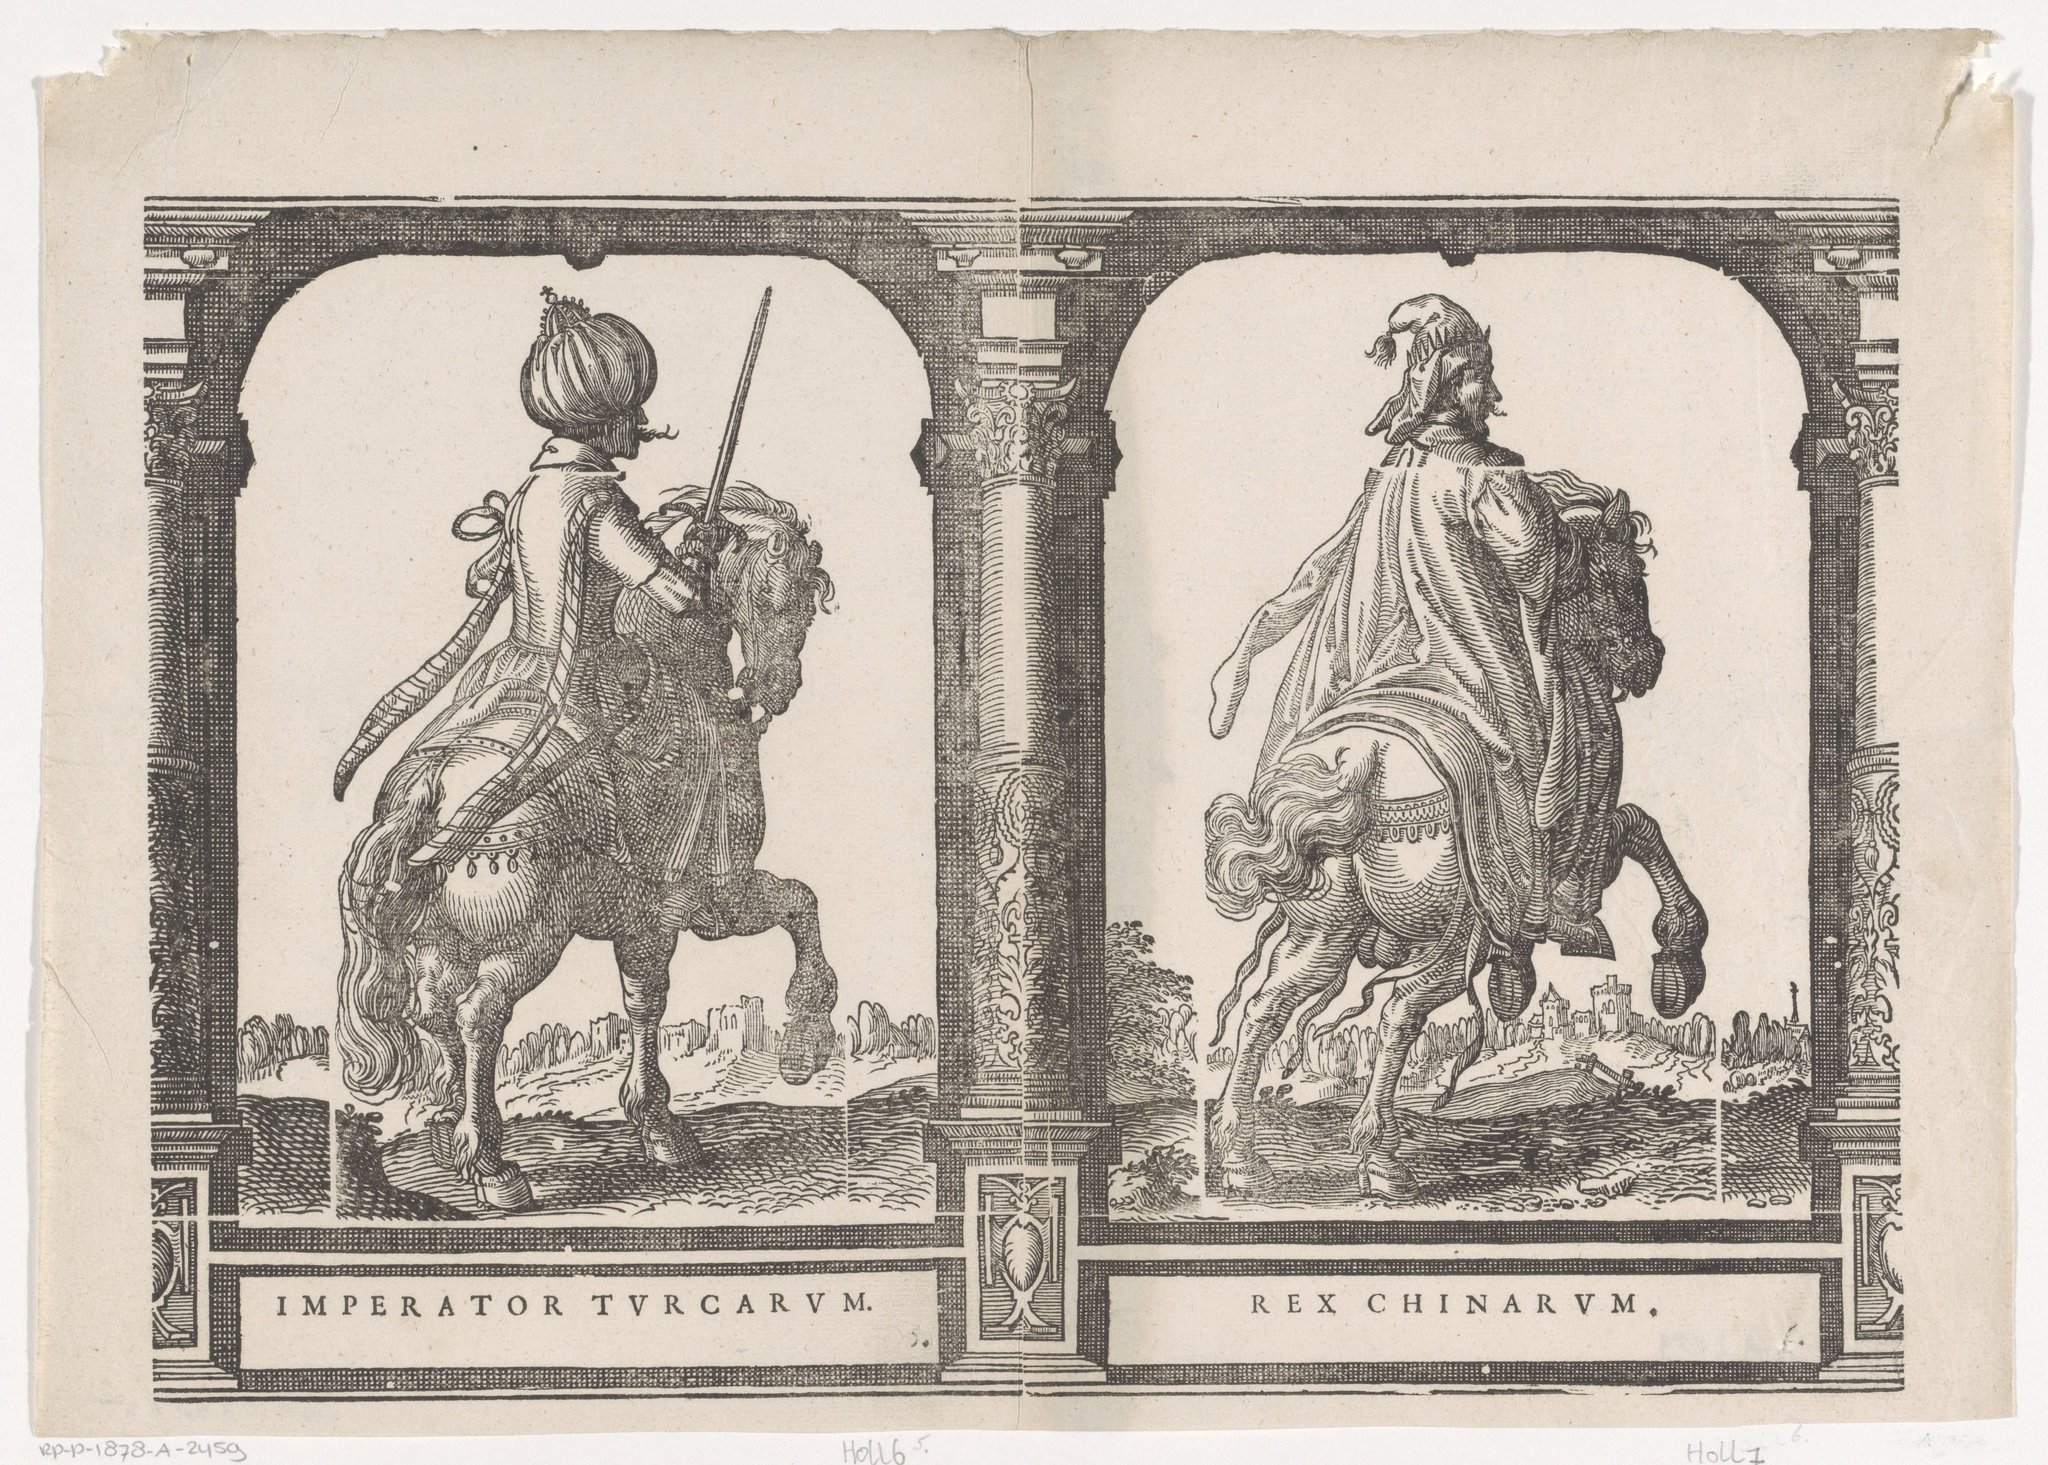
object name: print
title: Soevereinen te paard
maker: philips serwouters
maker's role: print maker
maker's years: 1591-1650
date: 1601-1650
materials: paper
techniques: letterpress printing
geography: netherlands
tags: equestrian state-portrait, emperor, king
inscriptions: collector's mark: Lugt 2228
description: Blad met een ruiterportret van een keizer van Turkije en een ruiterportret van een koning van China, elk in een geornamenteerde omlijsting met zuilen en in een kader zijn titel.